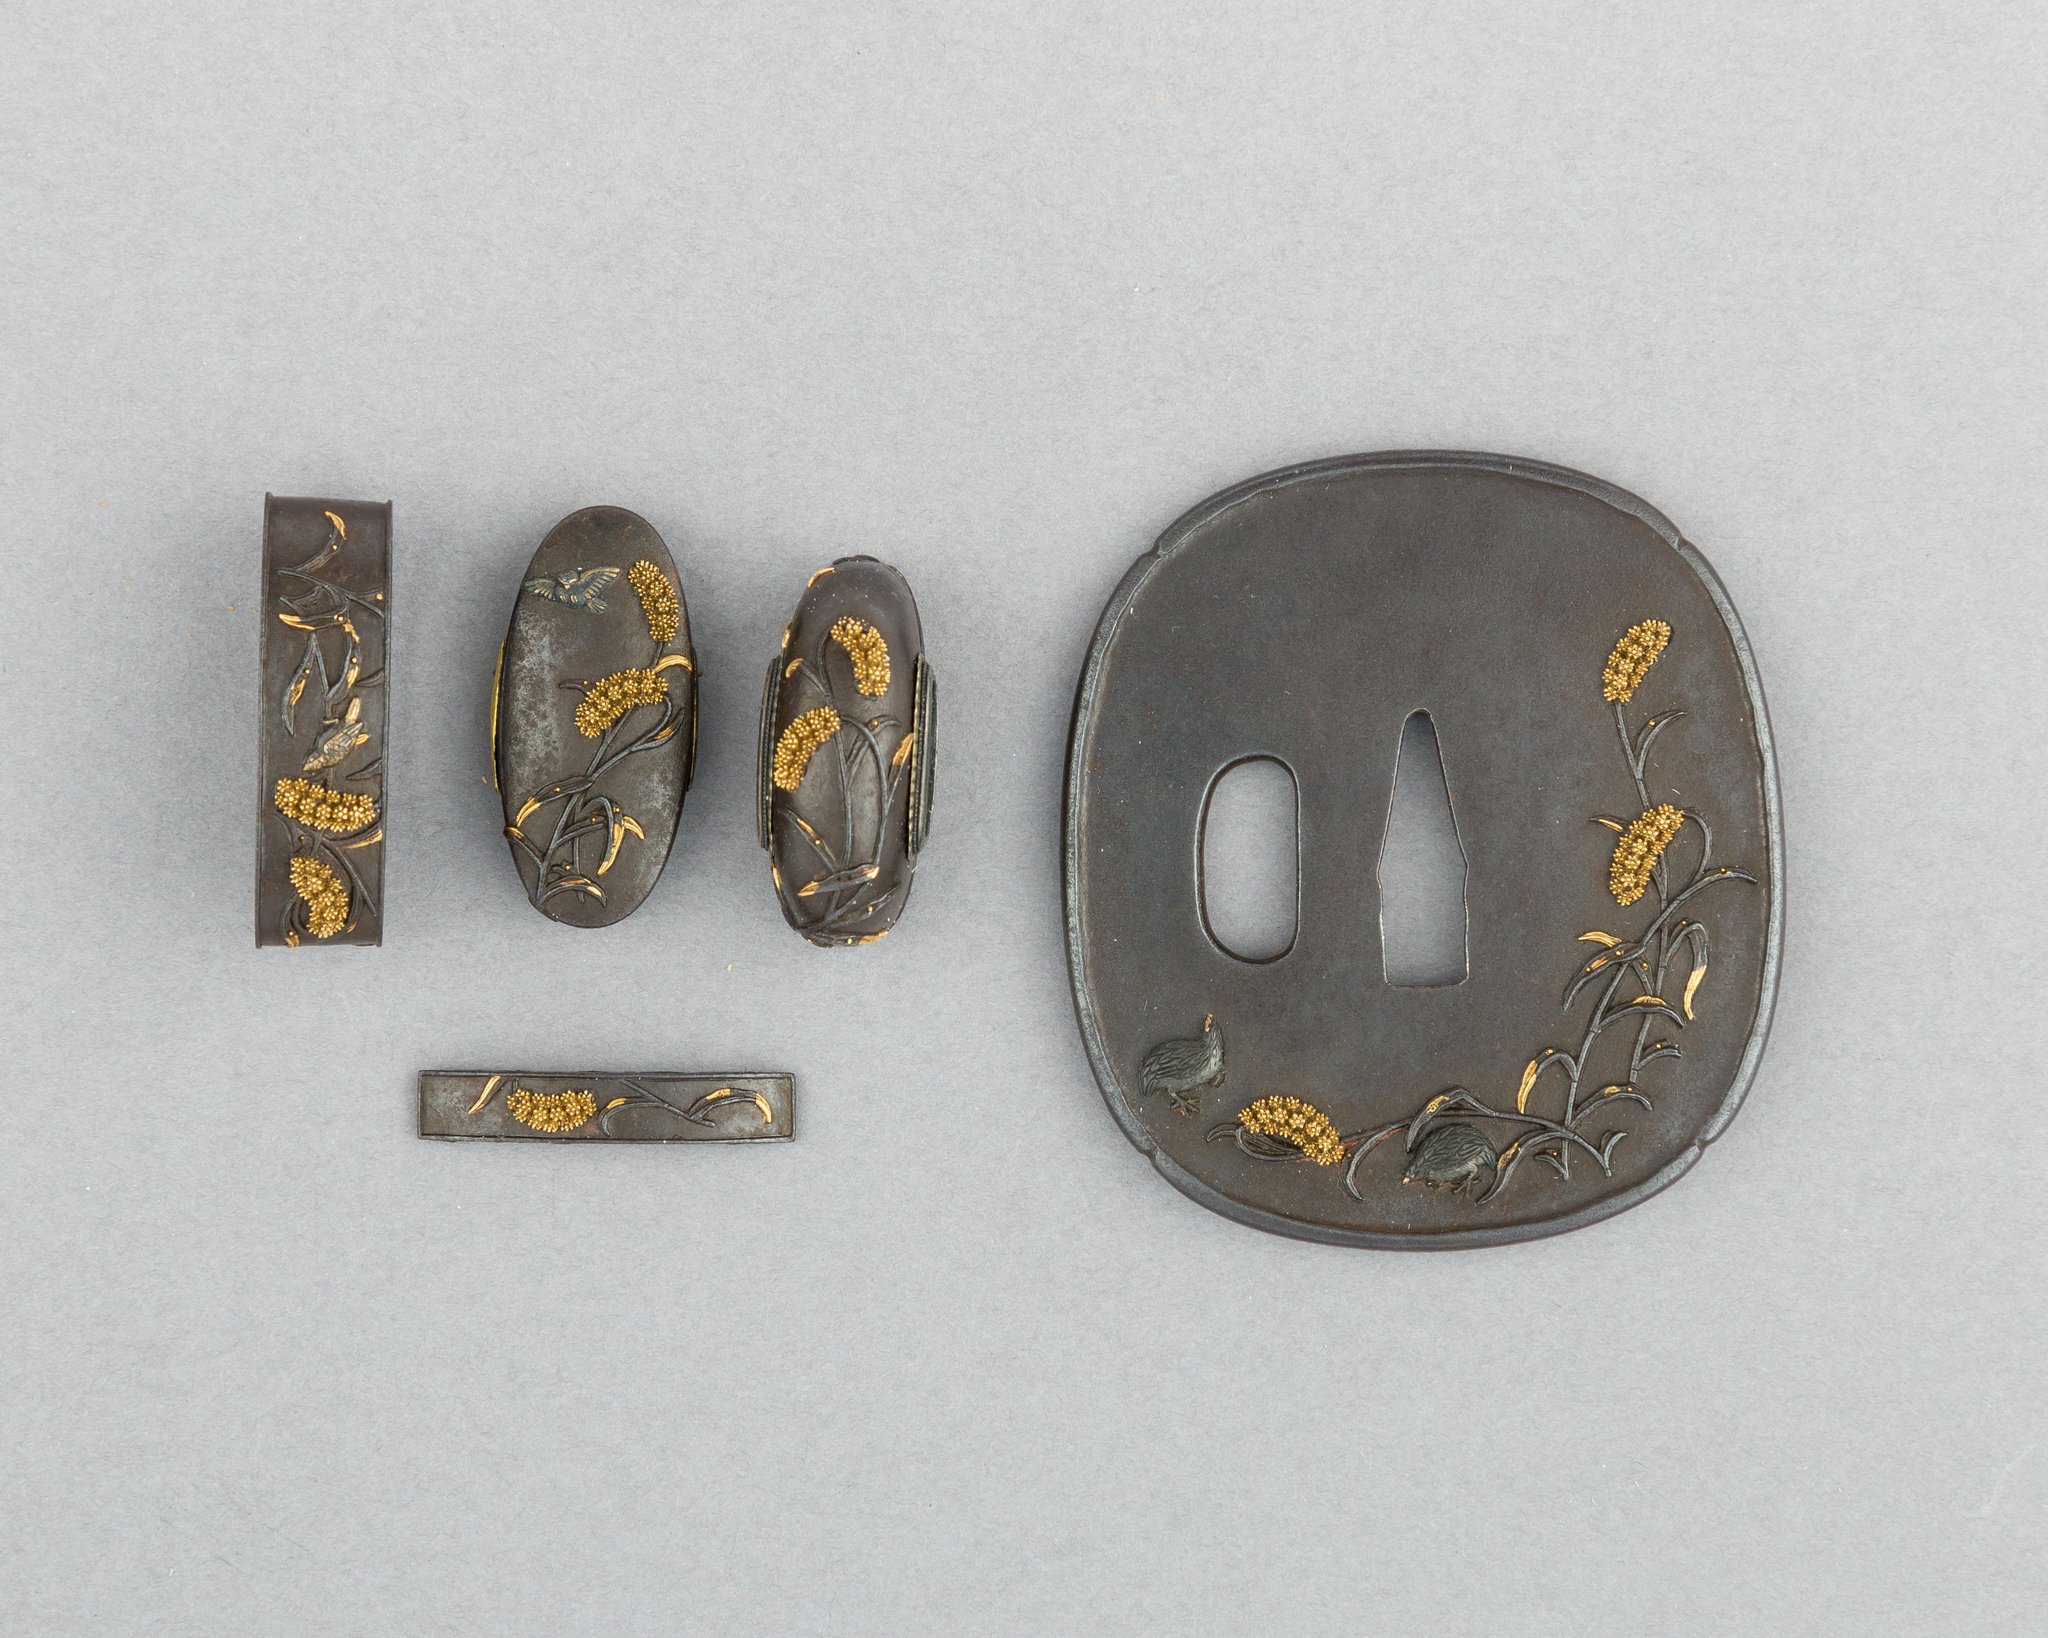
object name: set of sword fitting mitokoromono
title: Set of Sword Fittings (Mitokoromono)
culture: japanese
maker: ginshōtei tōmei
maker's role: fittings maker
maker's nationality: japanese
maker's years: 1817-1870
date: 1801-1900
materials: silver alloy, gold, iron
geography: japan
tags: plants